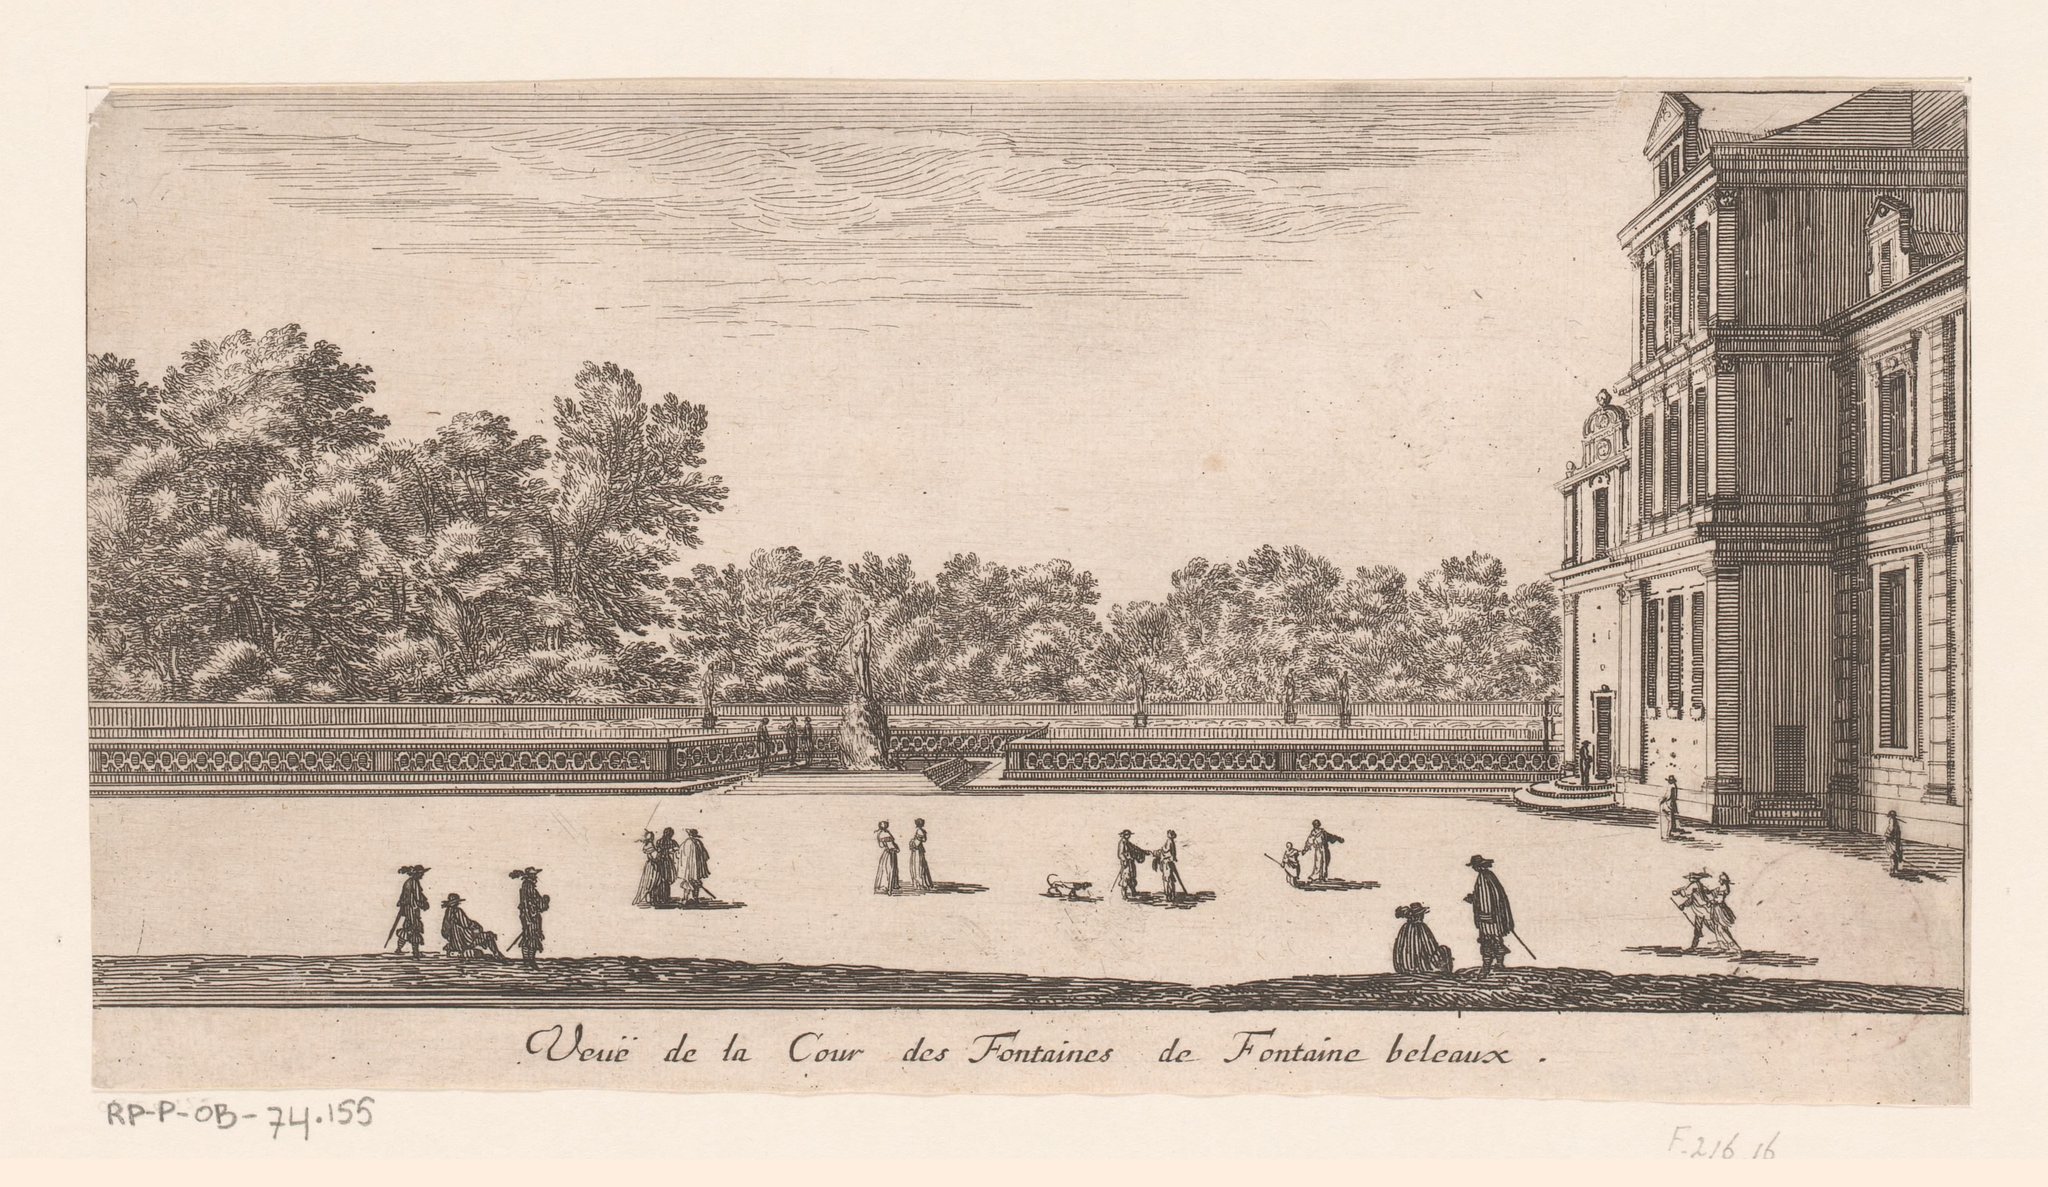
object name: print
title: Diverse vues du Château et des bâtiments de Fontainebleau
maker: israël silvestre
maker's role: draughtsman, print maker, publisher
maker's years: 1621-1691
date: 1631-1691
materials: paper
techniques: engraving, etching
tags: french or architectonic garden; formal garden, landscape with tower or castle (+ city(-scape) with figures, staffage)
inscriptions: collector's mark: Lugt 240